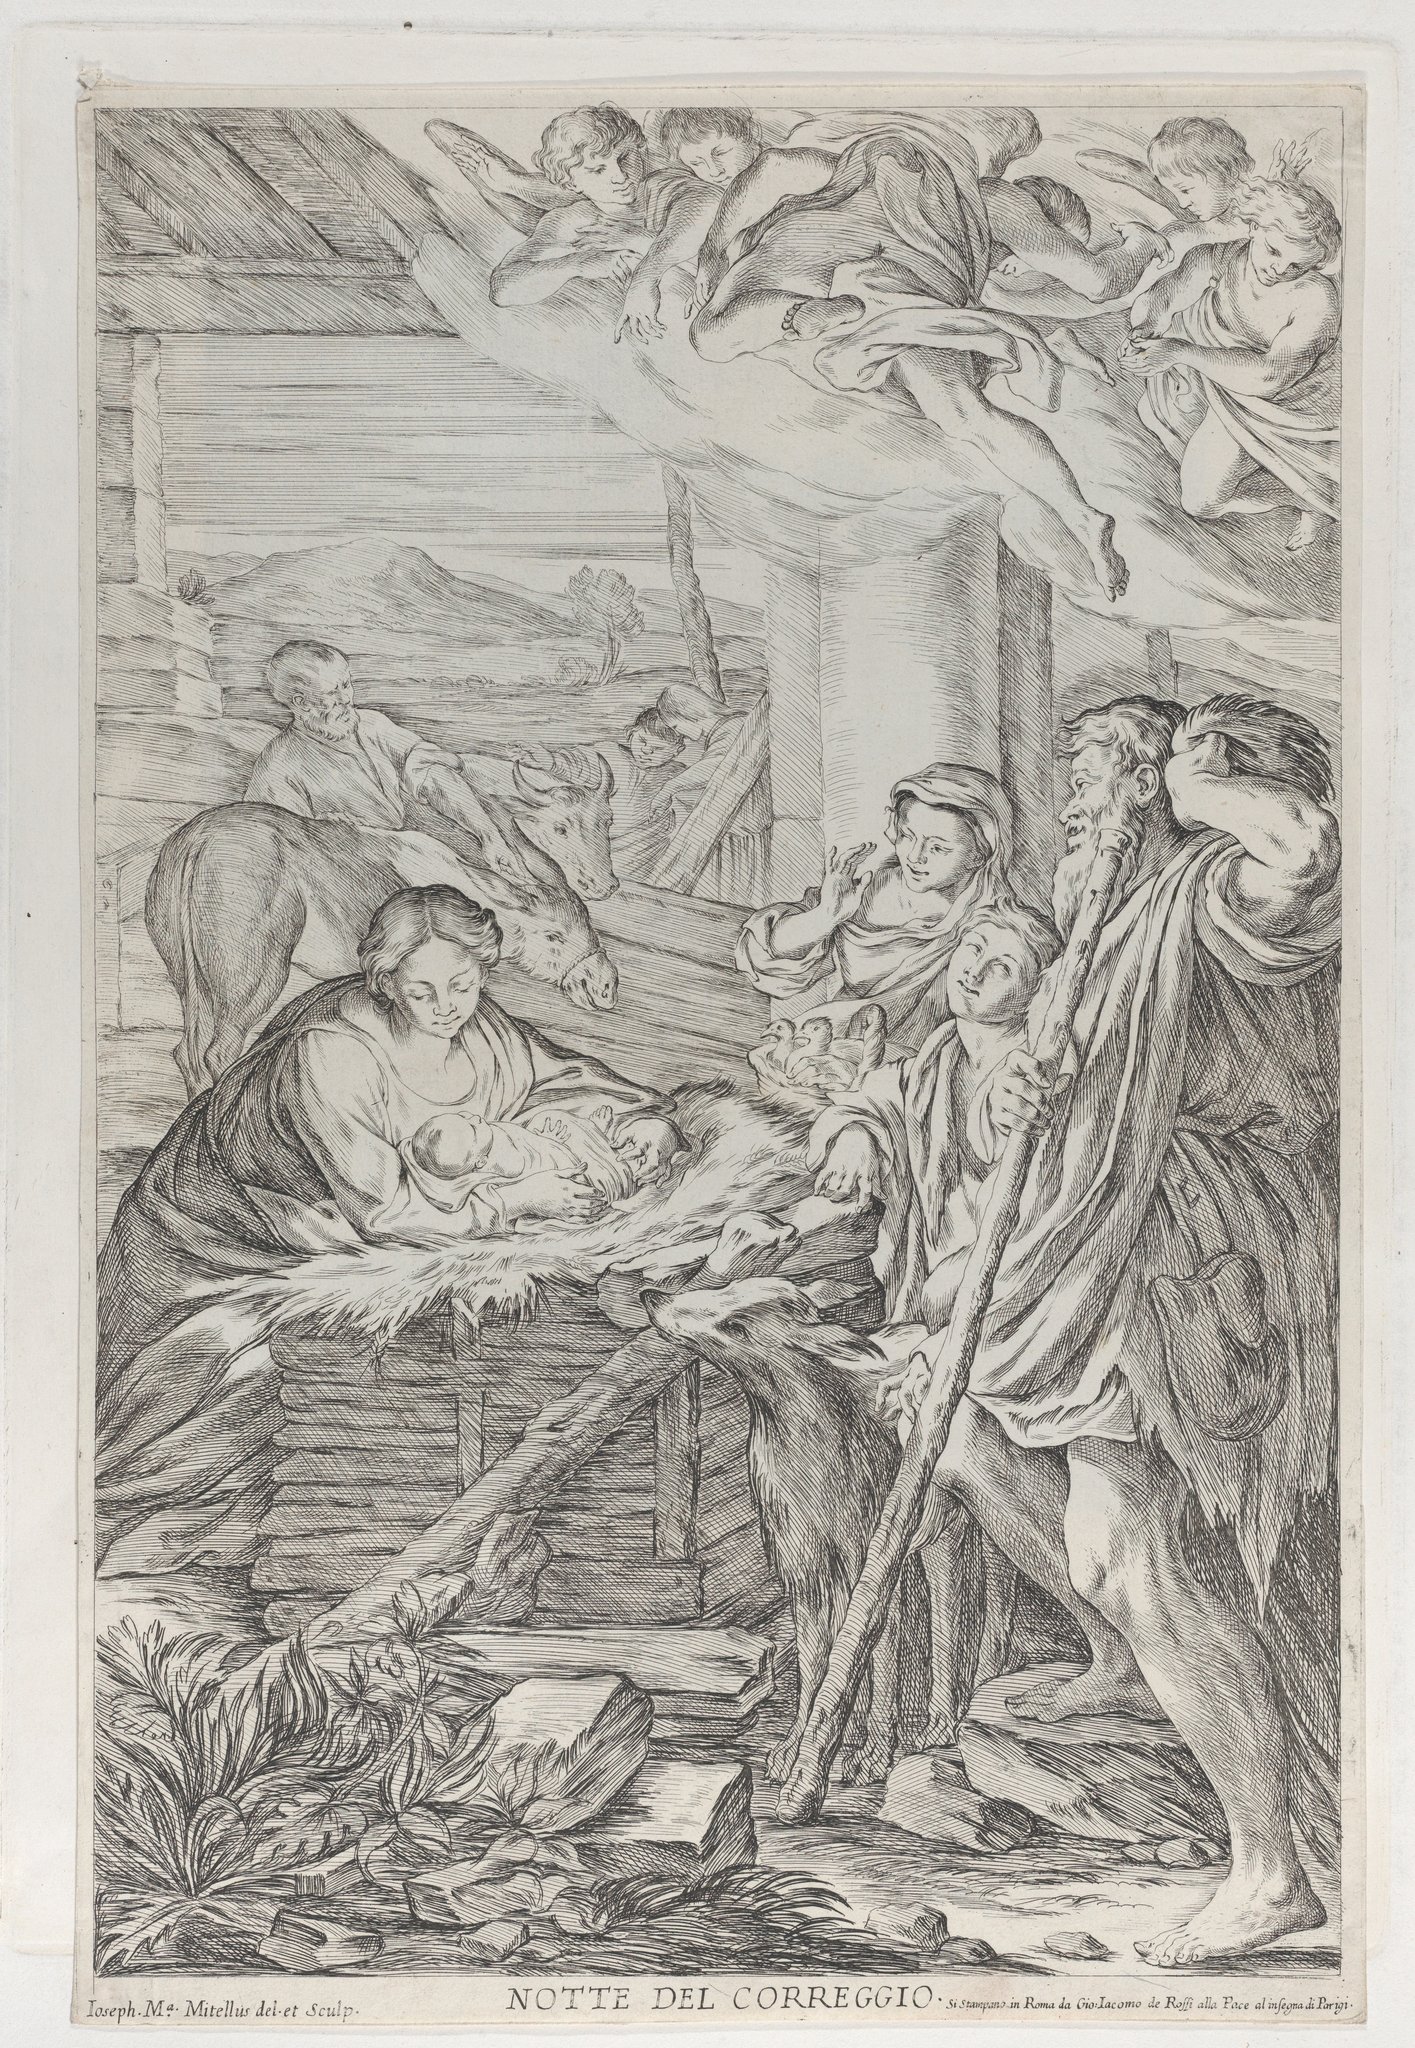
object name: print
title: Adoration of the Shepherds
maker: giuseppe maria mitelli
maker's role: artist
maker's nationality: italian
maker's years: 1634-1718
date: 1654-1718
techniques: etching